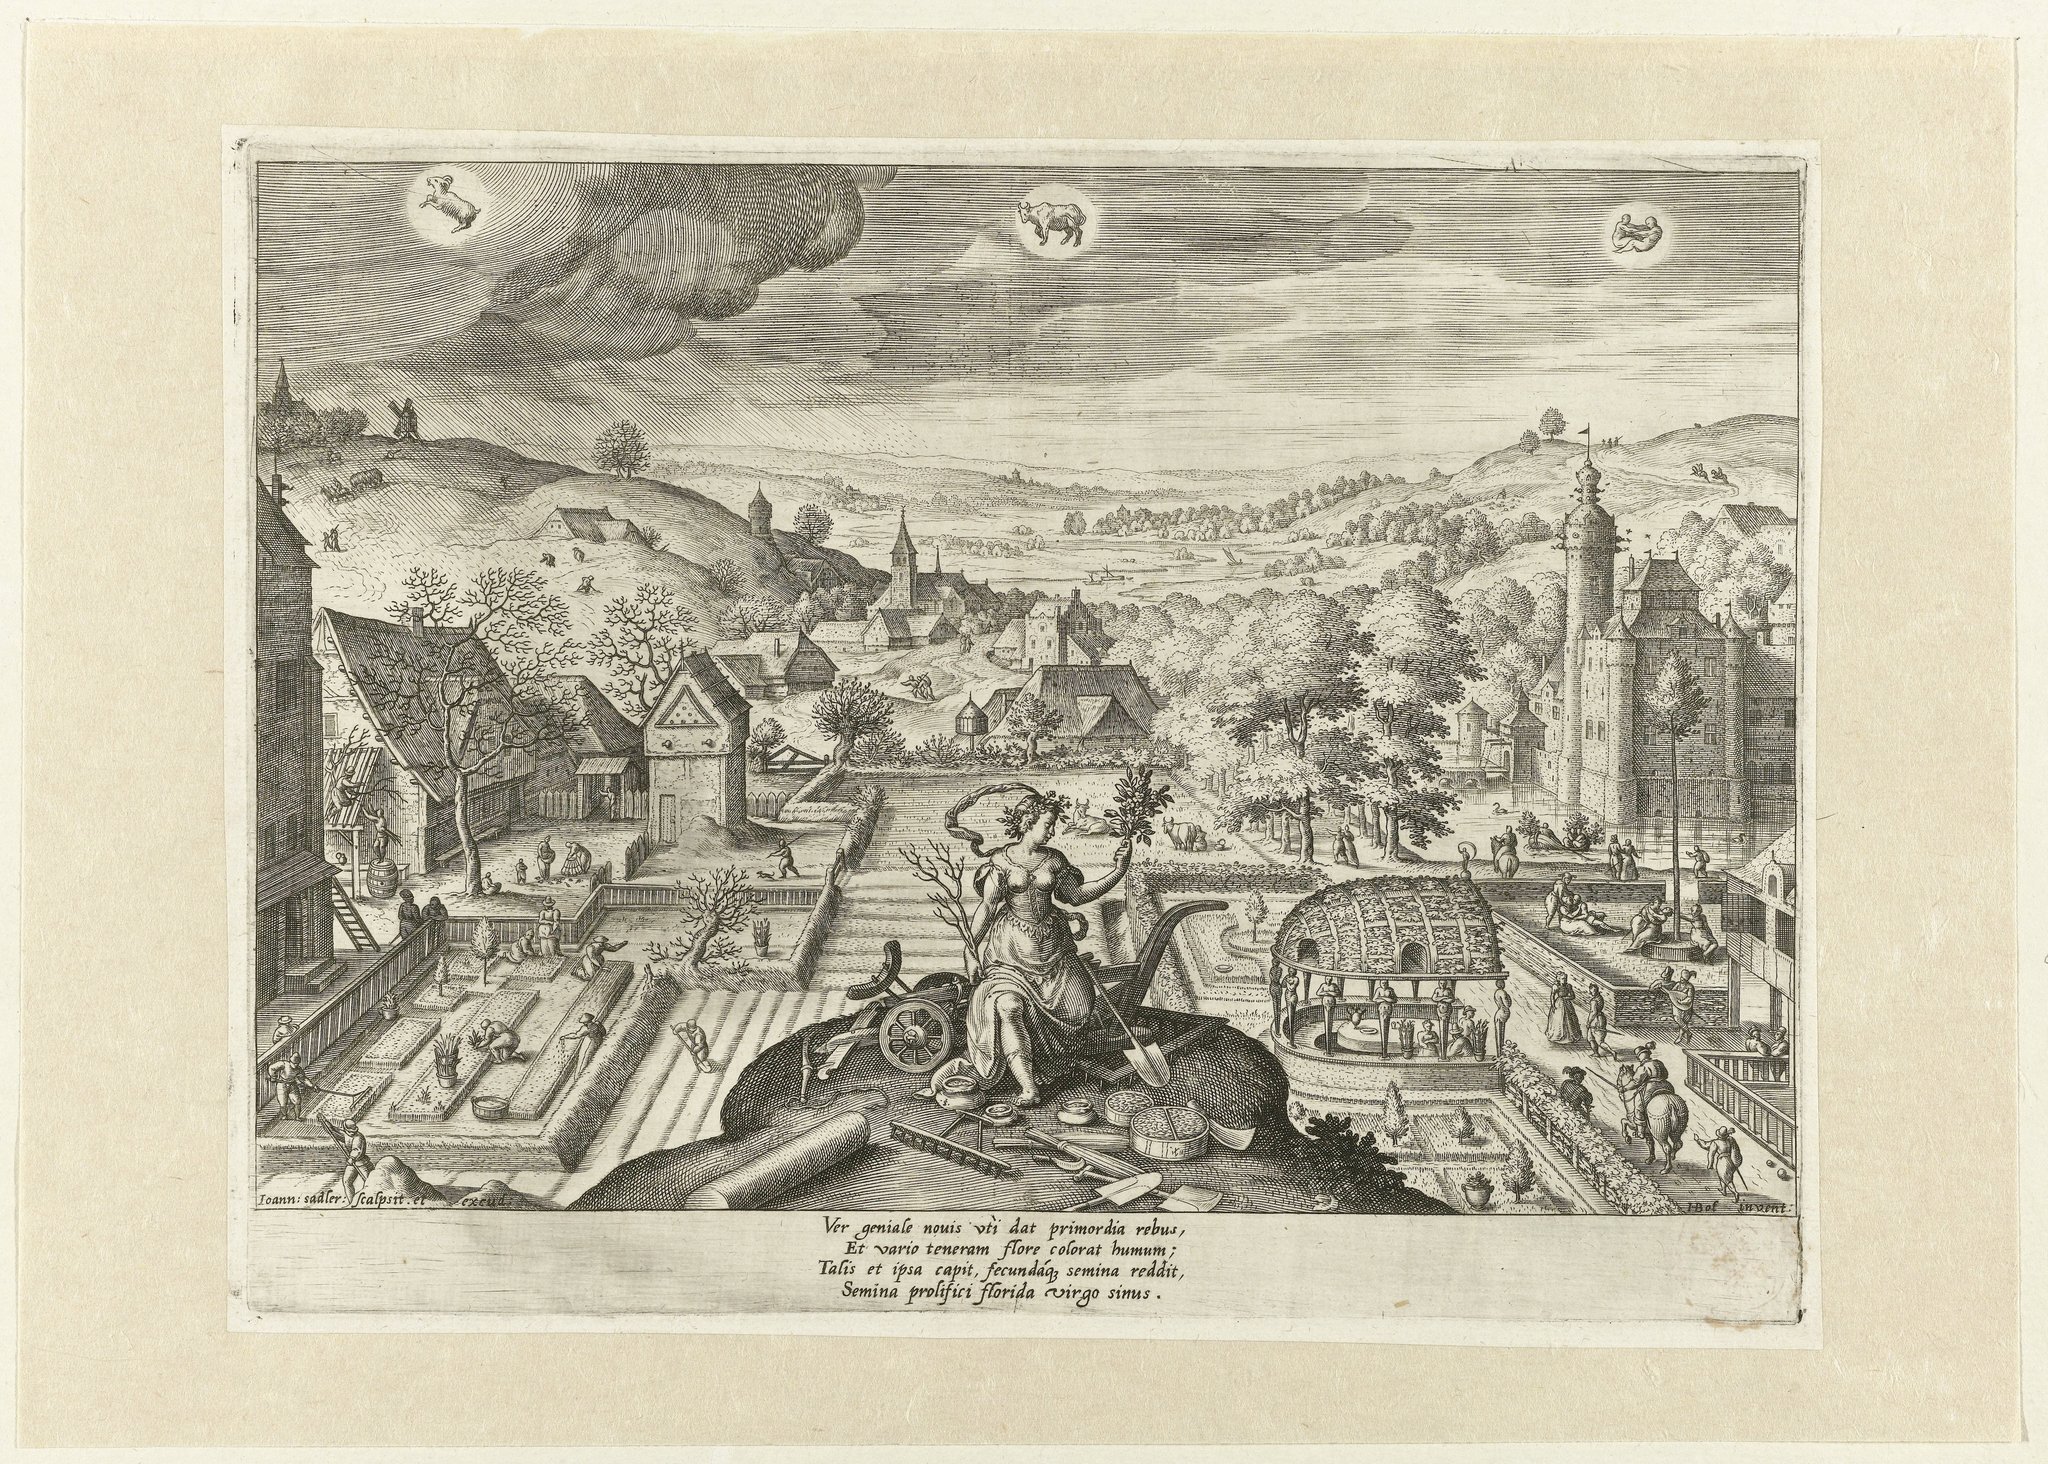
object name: print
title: De vier seizoenen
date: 1580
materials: paper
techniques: engraving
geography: cologne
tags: cultivation of (ornamental) garden, castle, spring ~ human activities (the four seasons of the year), pergola, gardening-tools, zodiacal signs of the spring season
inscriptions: collector's mark: Lugt 240, caption: ‘Ver...sinus’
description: De Lente. De vrouwelijke personificatie van het seizoen van de Lente met bloemtakken in de handen, zittend in het midden op de voorgrond. Om haar heen op de grond ligt tuingereedschap. In het landschap achter haar worden tuinen verzorgd. Rechts een pergola en een kasteel. In de hemel de sterrenbeelden: Steenbok, Stier en Tweelingen. In het onderschrift een vers van 4 regels in het Latijn.